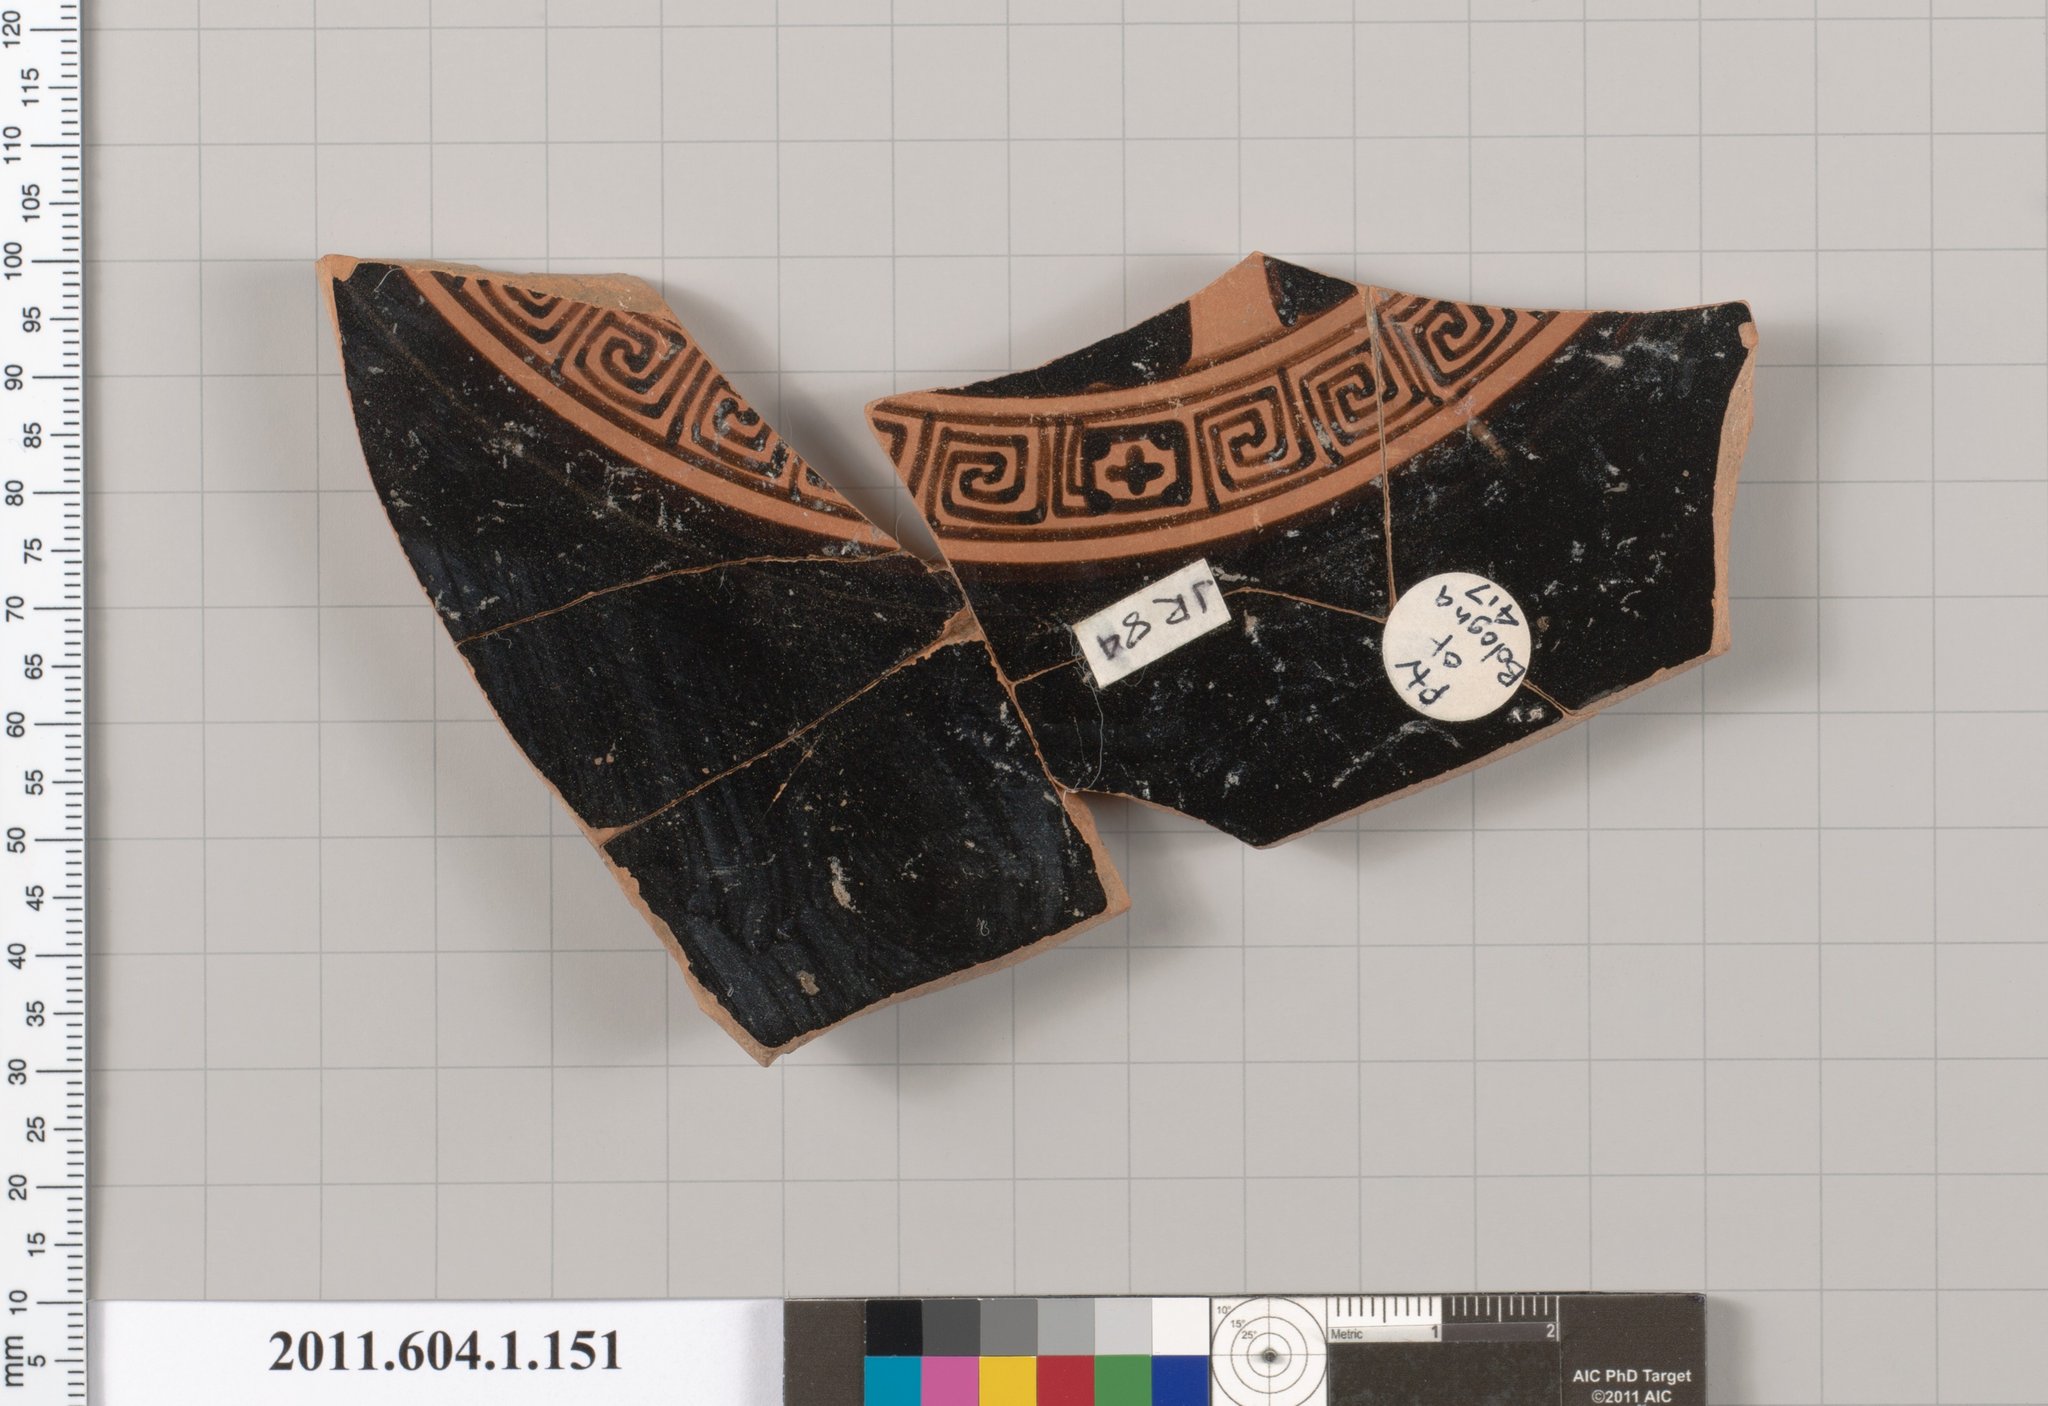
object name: kylix fragment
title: Terracotta fragment of a kylix (drinking cup)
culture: greek, attic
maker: painter of bologna 417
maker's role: artist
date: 475-451 BCE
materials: terracotta